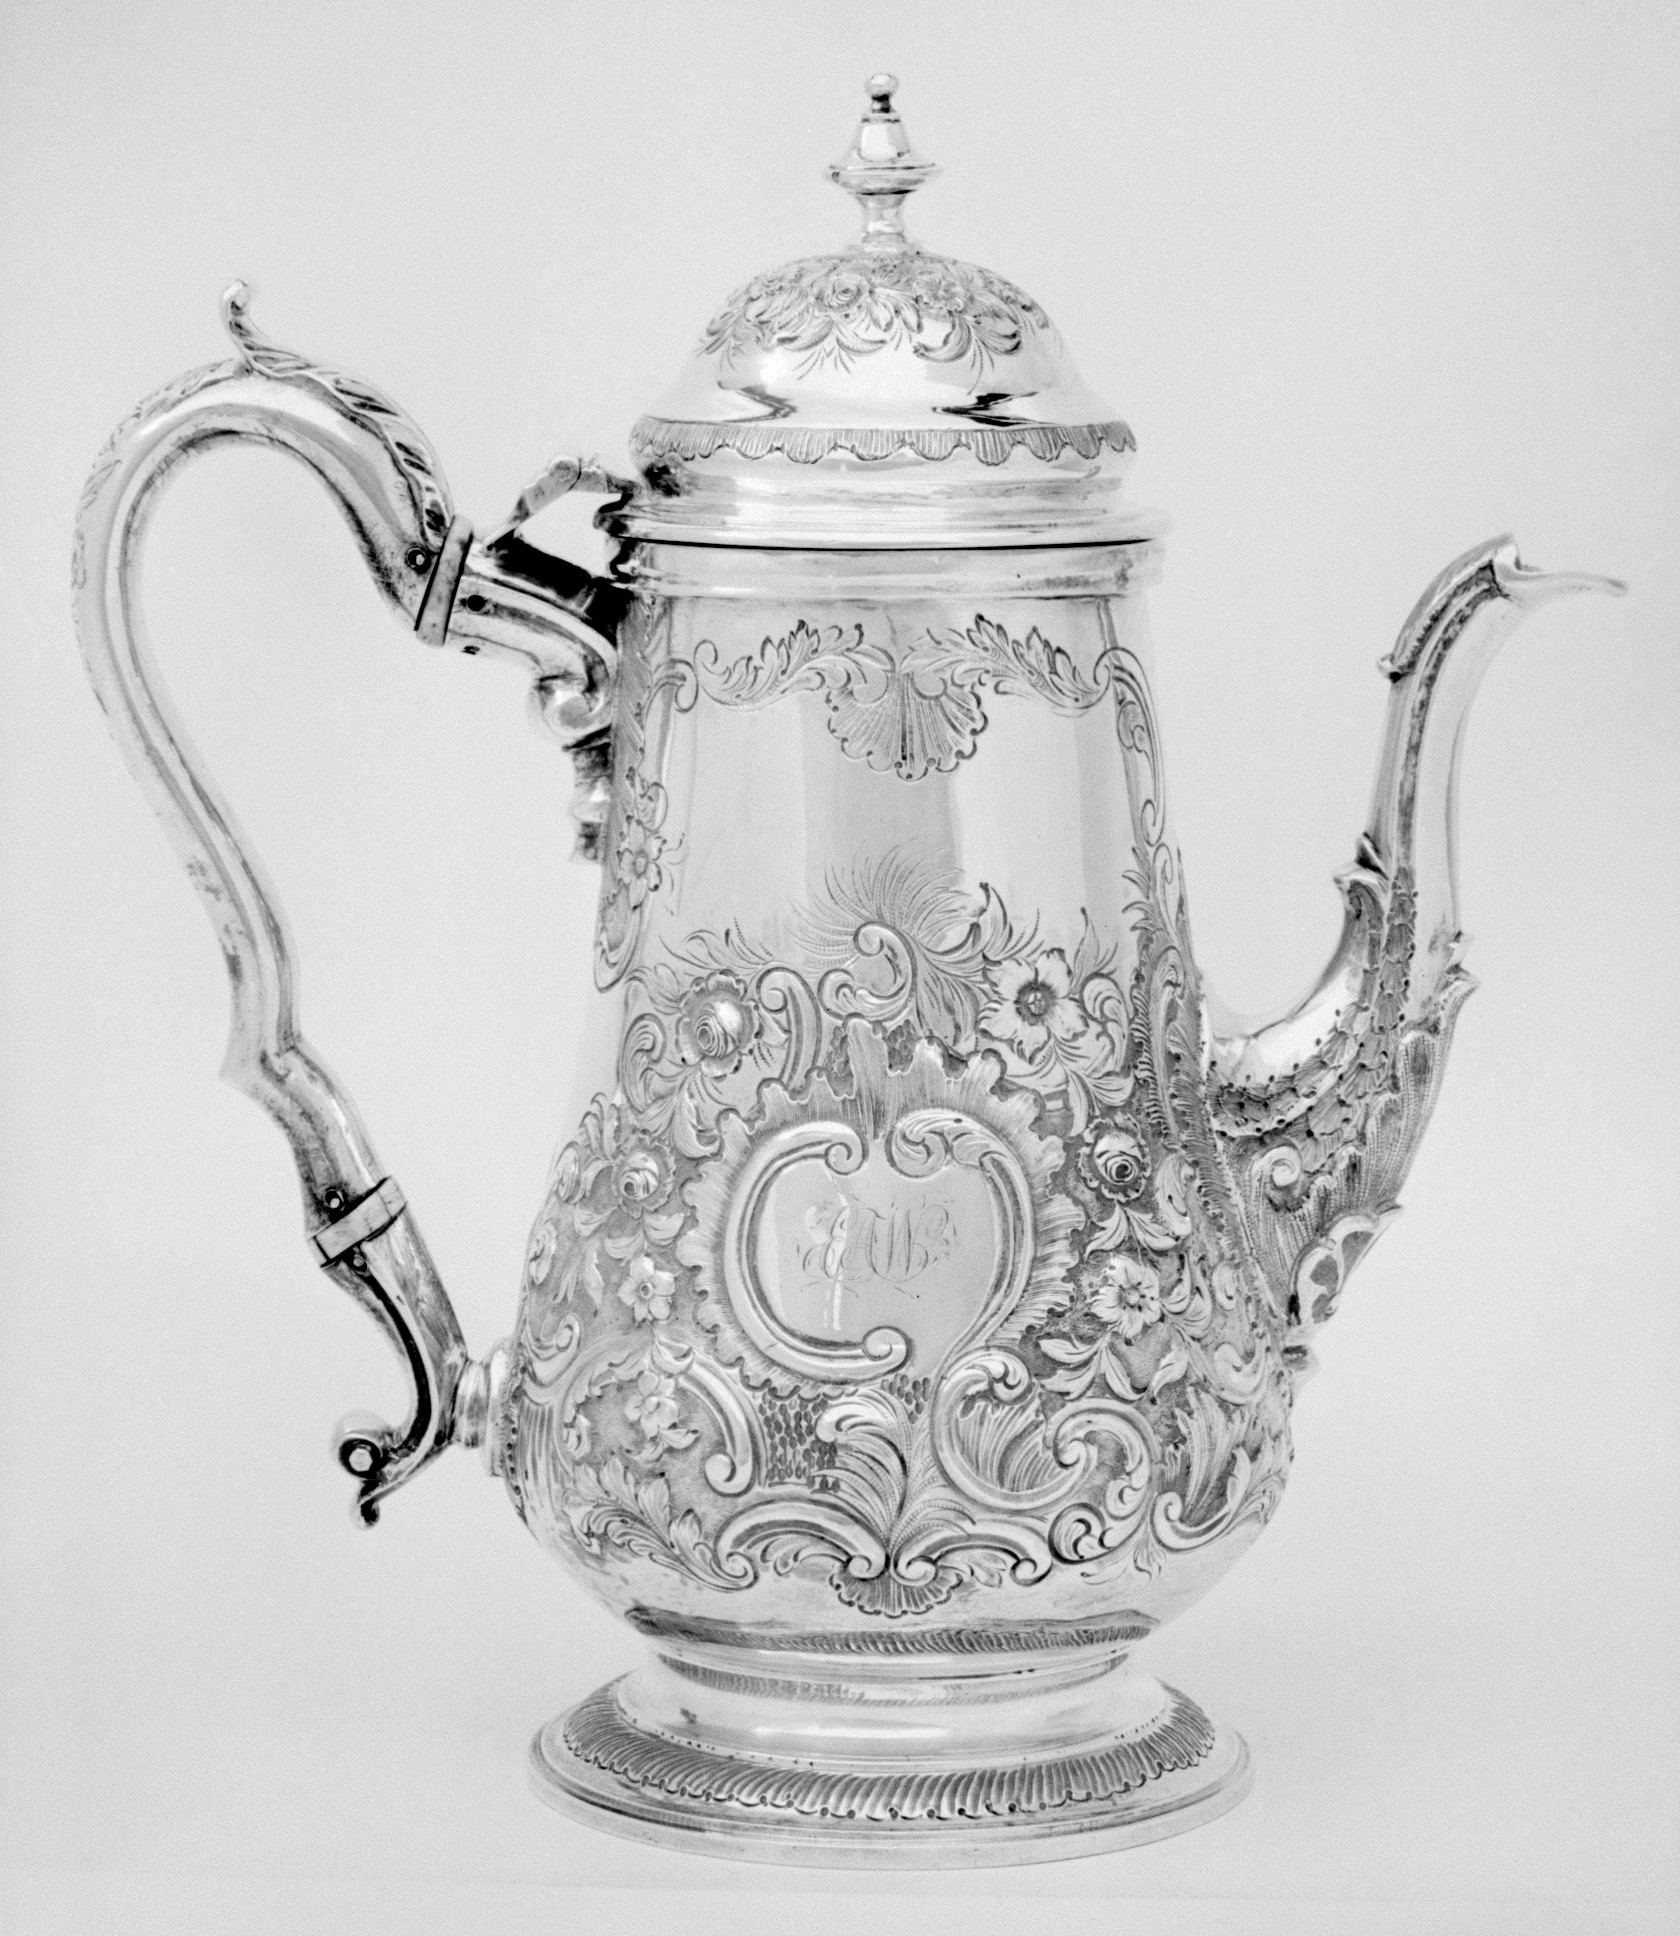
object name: coffeepot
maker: john swift ii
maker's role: maker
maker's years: 1696-1796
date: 1774-1775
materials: silver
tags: flowers,insignia